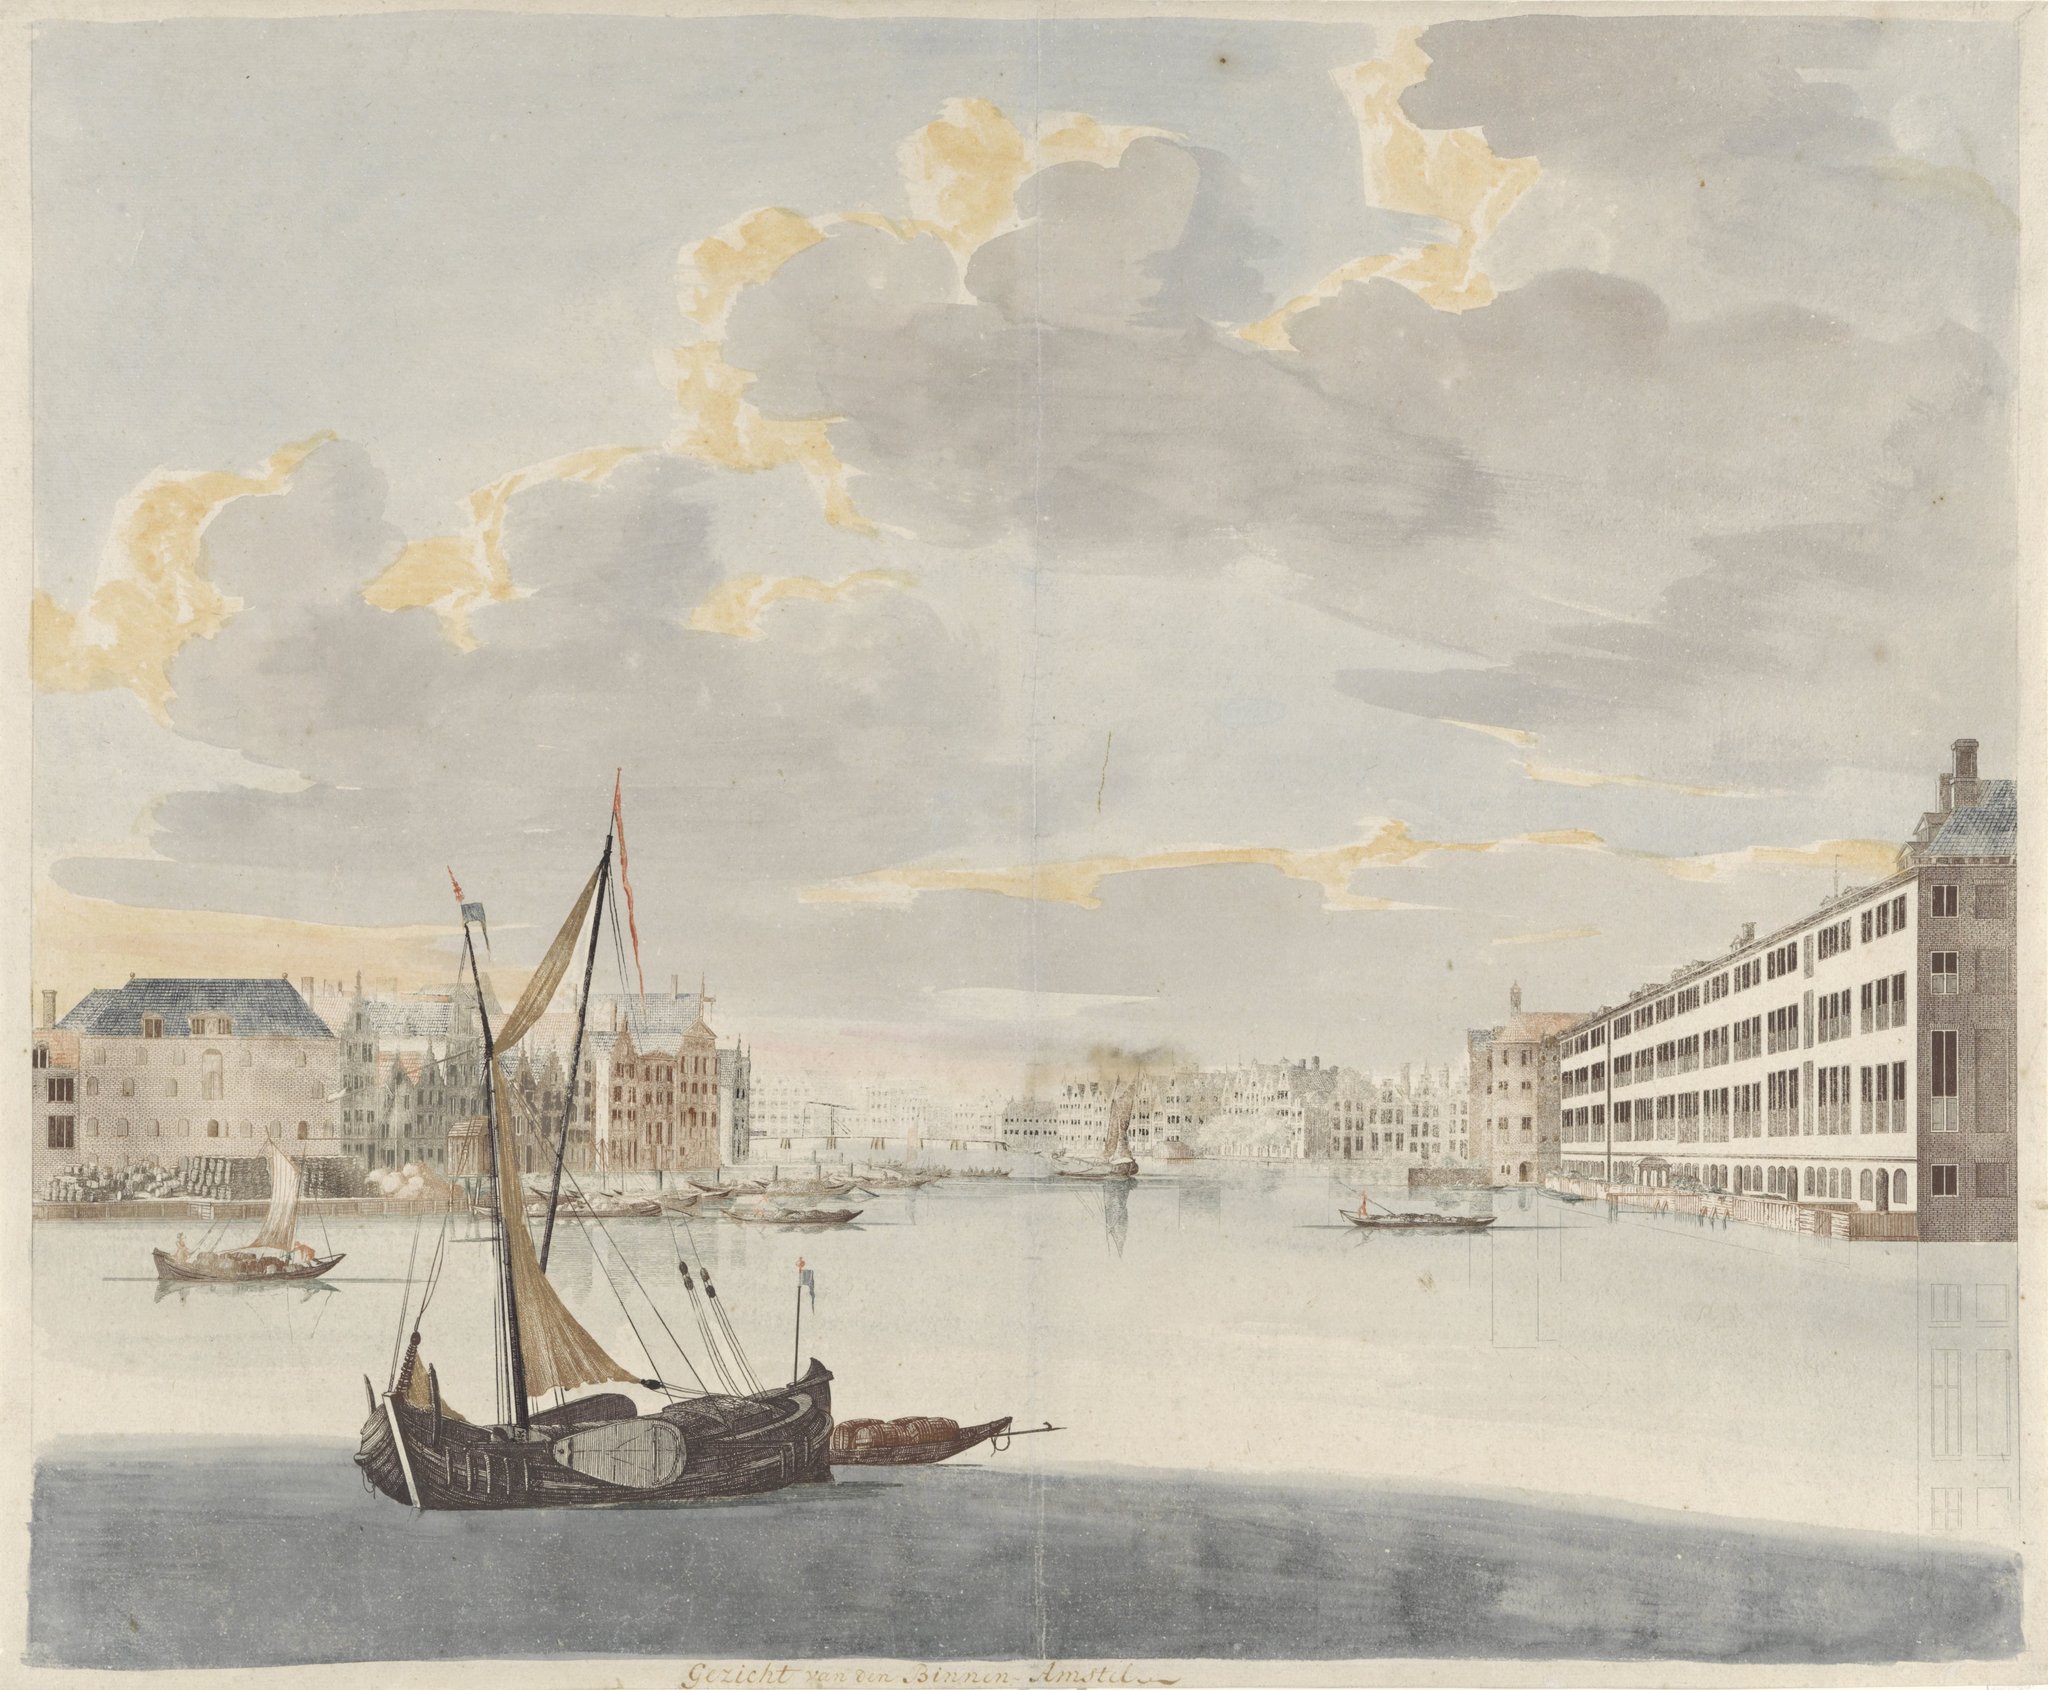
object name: print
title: Gezicht op de Binnen-Amstel in Amsterdam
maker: johan teyler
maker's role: draughtsman, print maker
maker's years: 1648-1712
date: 1658-1712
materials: paper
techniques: etching, hand coloring, lithography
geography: nijmegen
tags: sailing-ship, sailing-boat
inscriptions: inscription: ‘ze prent is uiterst zeldzaam. behoorende tot het chromatische werk van Joh. Teiler, zie catalogus van Fred: Muller 18120 April 1868’, inscription: ‘Gezicht van den Binnen-Amstel’, collector's mark: Lugt 2228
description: Verschillende schuiten en zeilschip op de voorgrond varen op de Binnen-Amstel in Amsterdam.